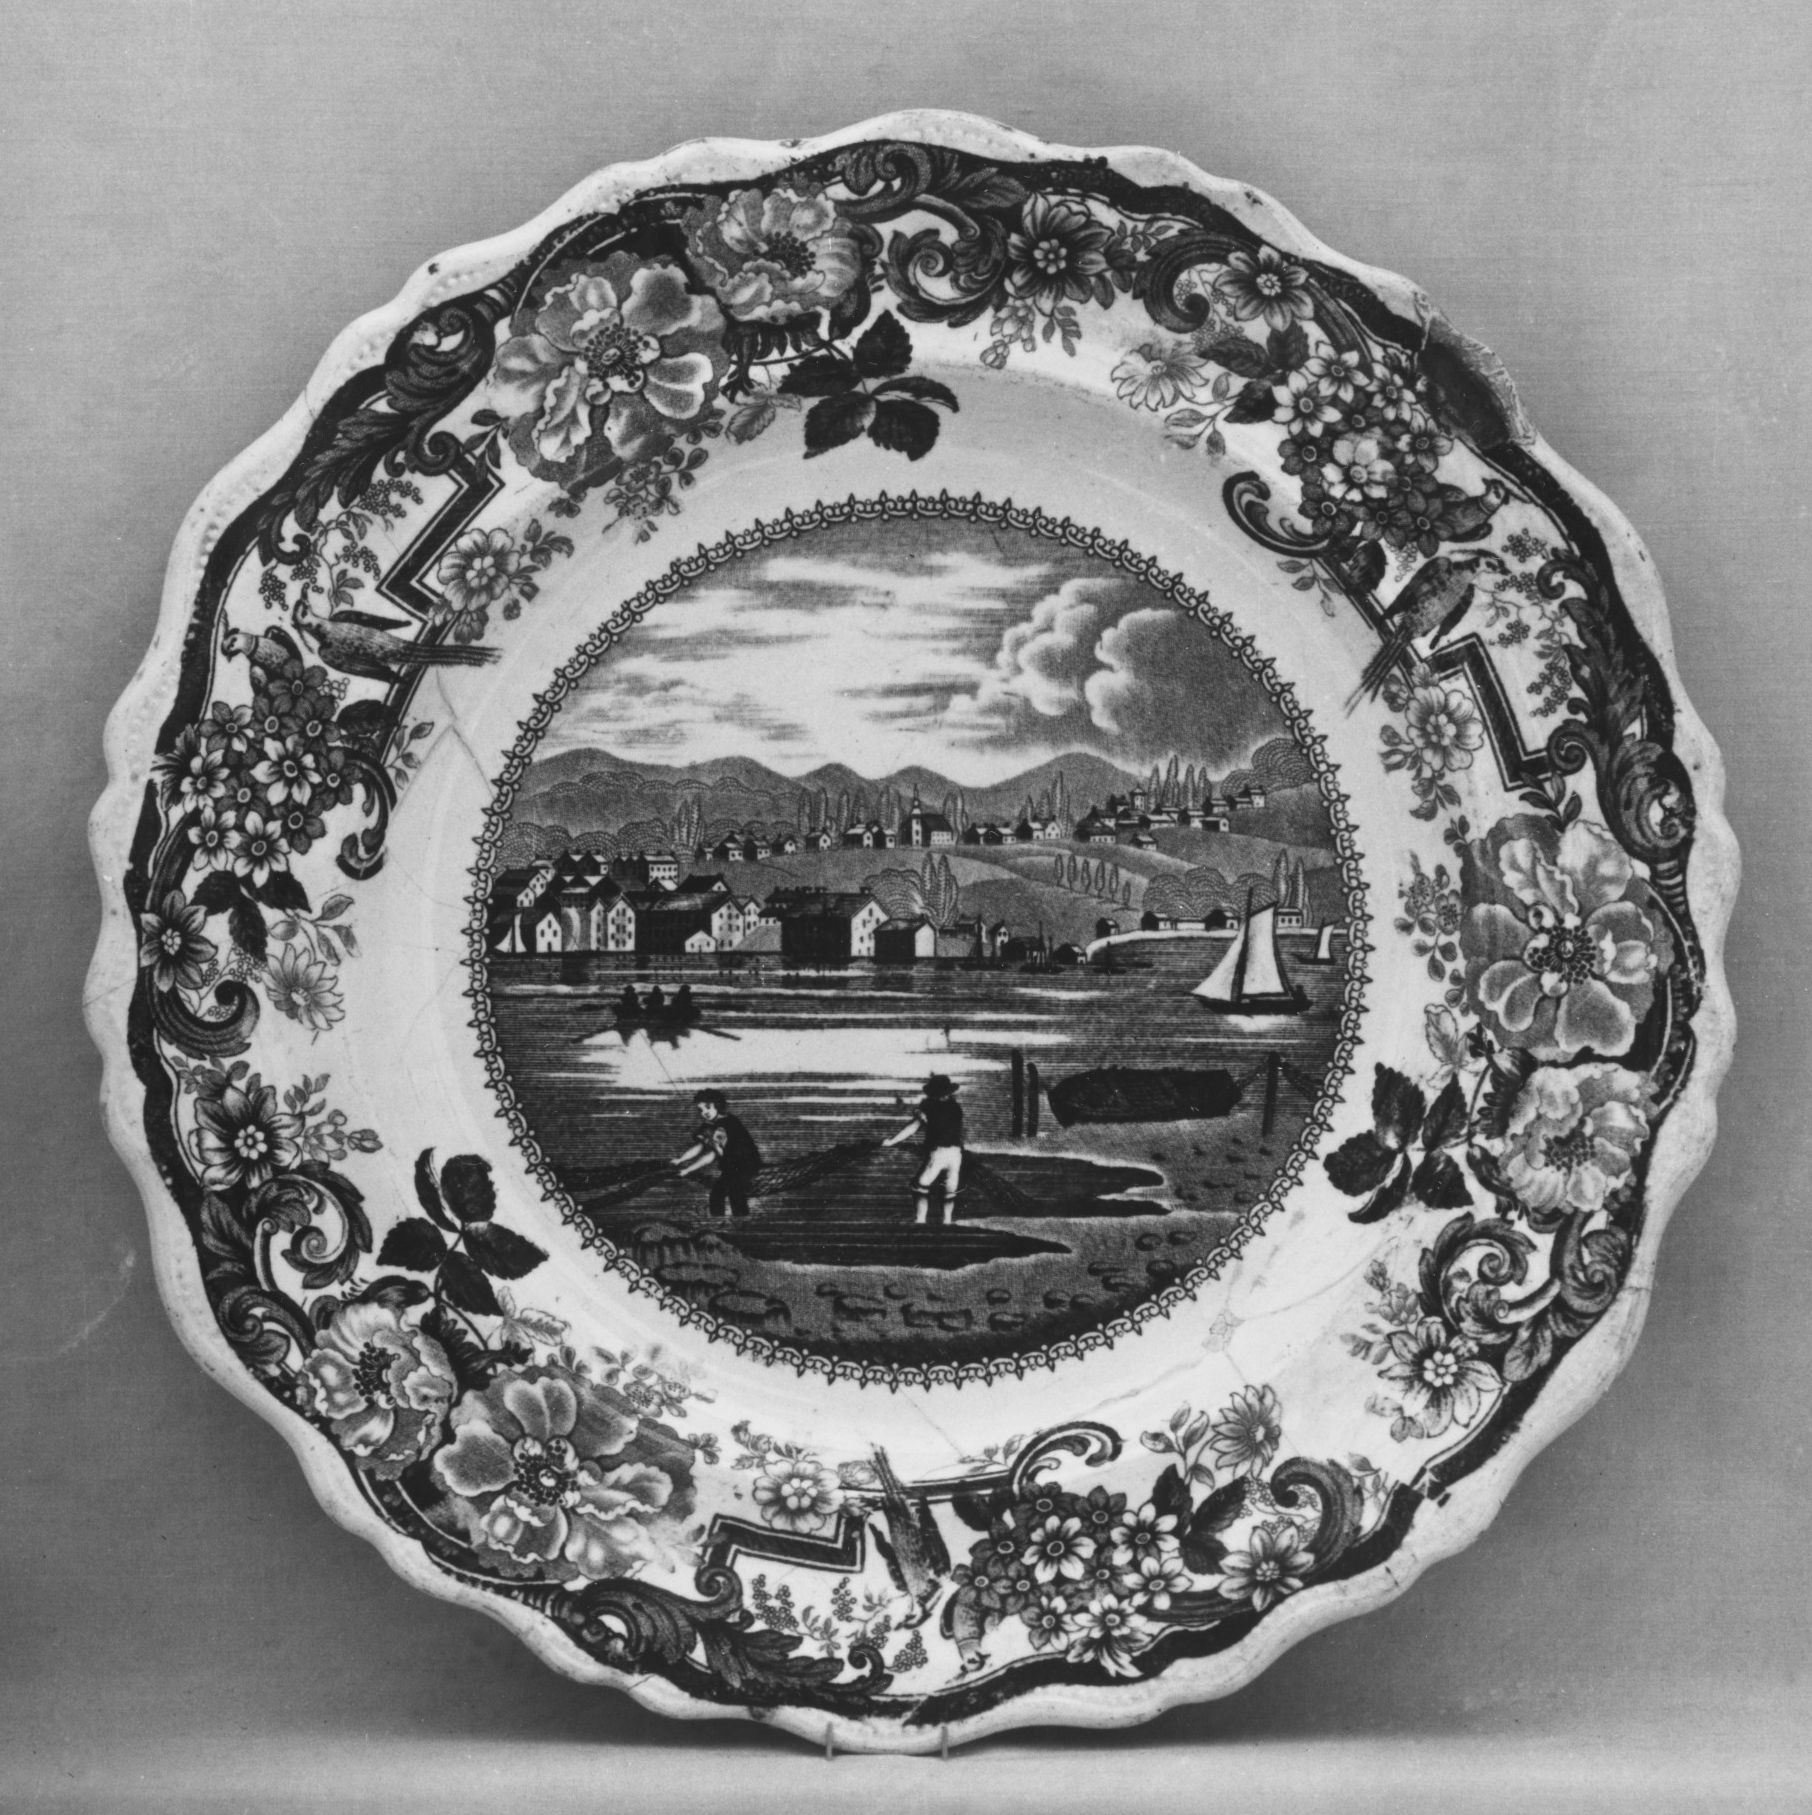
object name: plate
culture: british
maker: james and ralph clews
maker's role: maker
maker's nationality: british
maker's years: 1813-1836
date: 1815-1834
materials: earthenware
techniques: transfer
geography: england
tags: birds,landscapes,boats